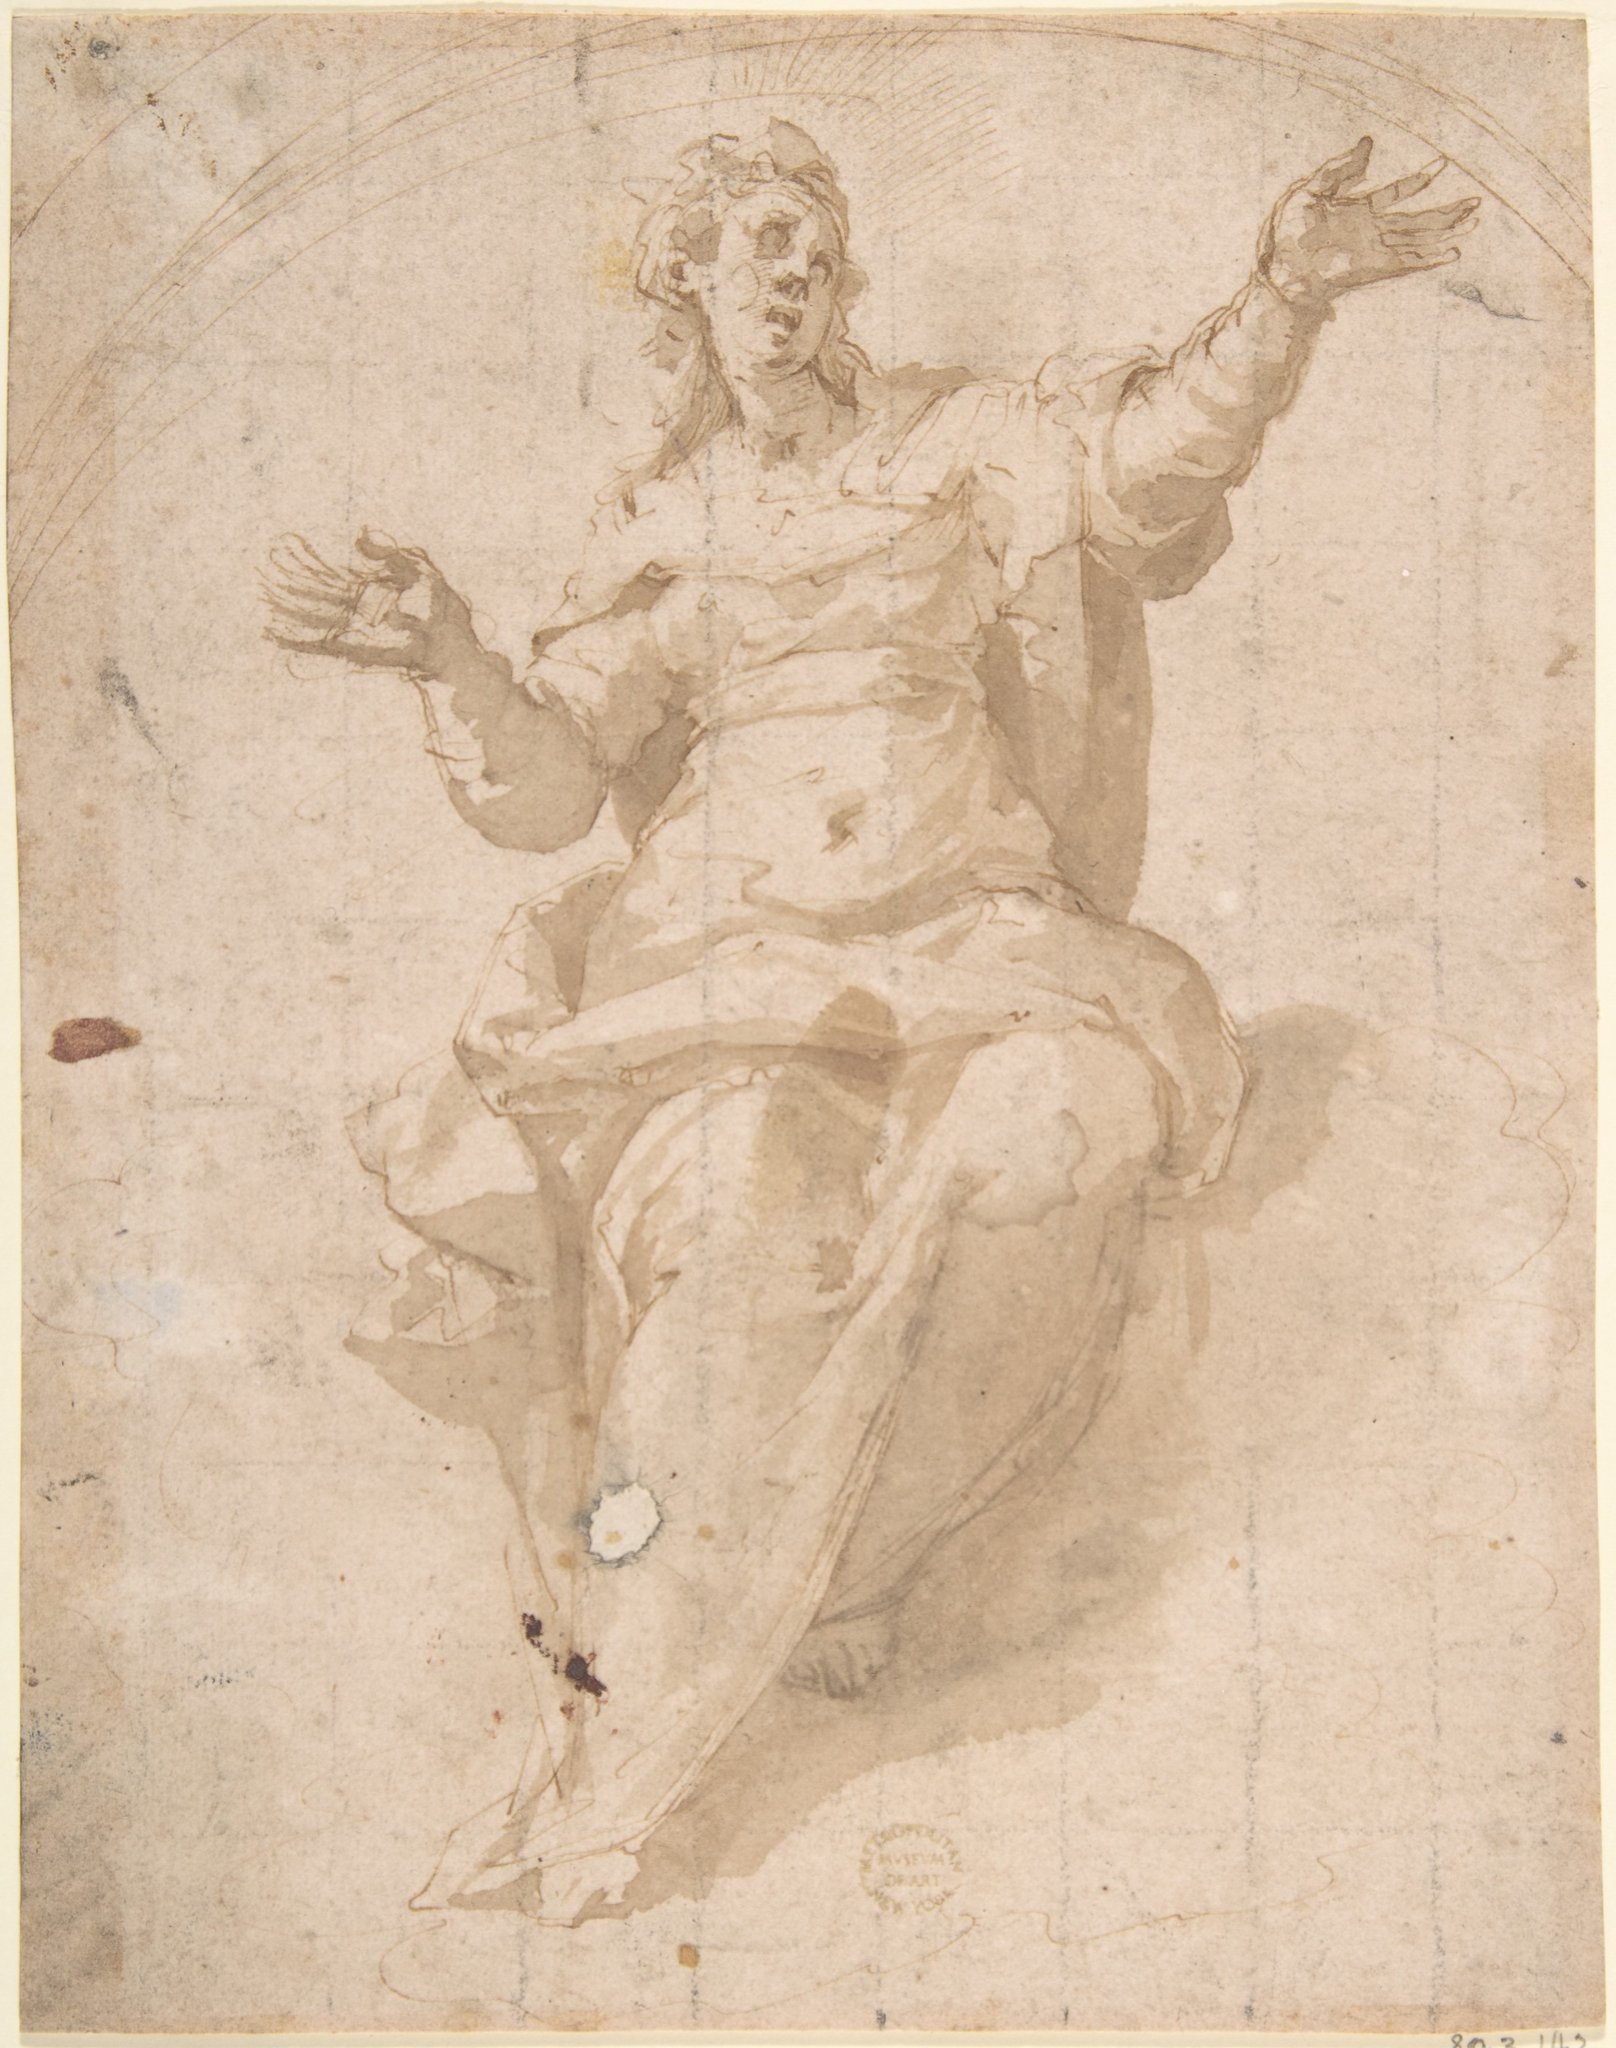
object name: drawing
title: Study for the Ascension of the Virgin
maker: marco pino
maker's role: artist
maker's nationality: italian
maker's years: 1525-1587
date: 1501-1600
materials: chalk, ink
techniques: brush, pen, drawing, wash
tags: virgin mary